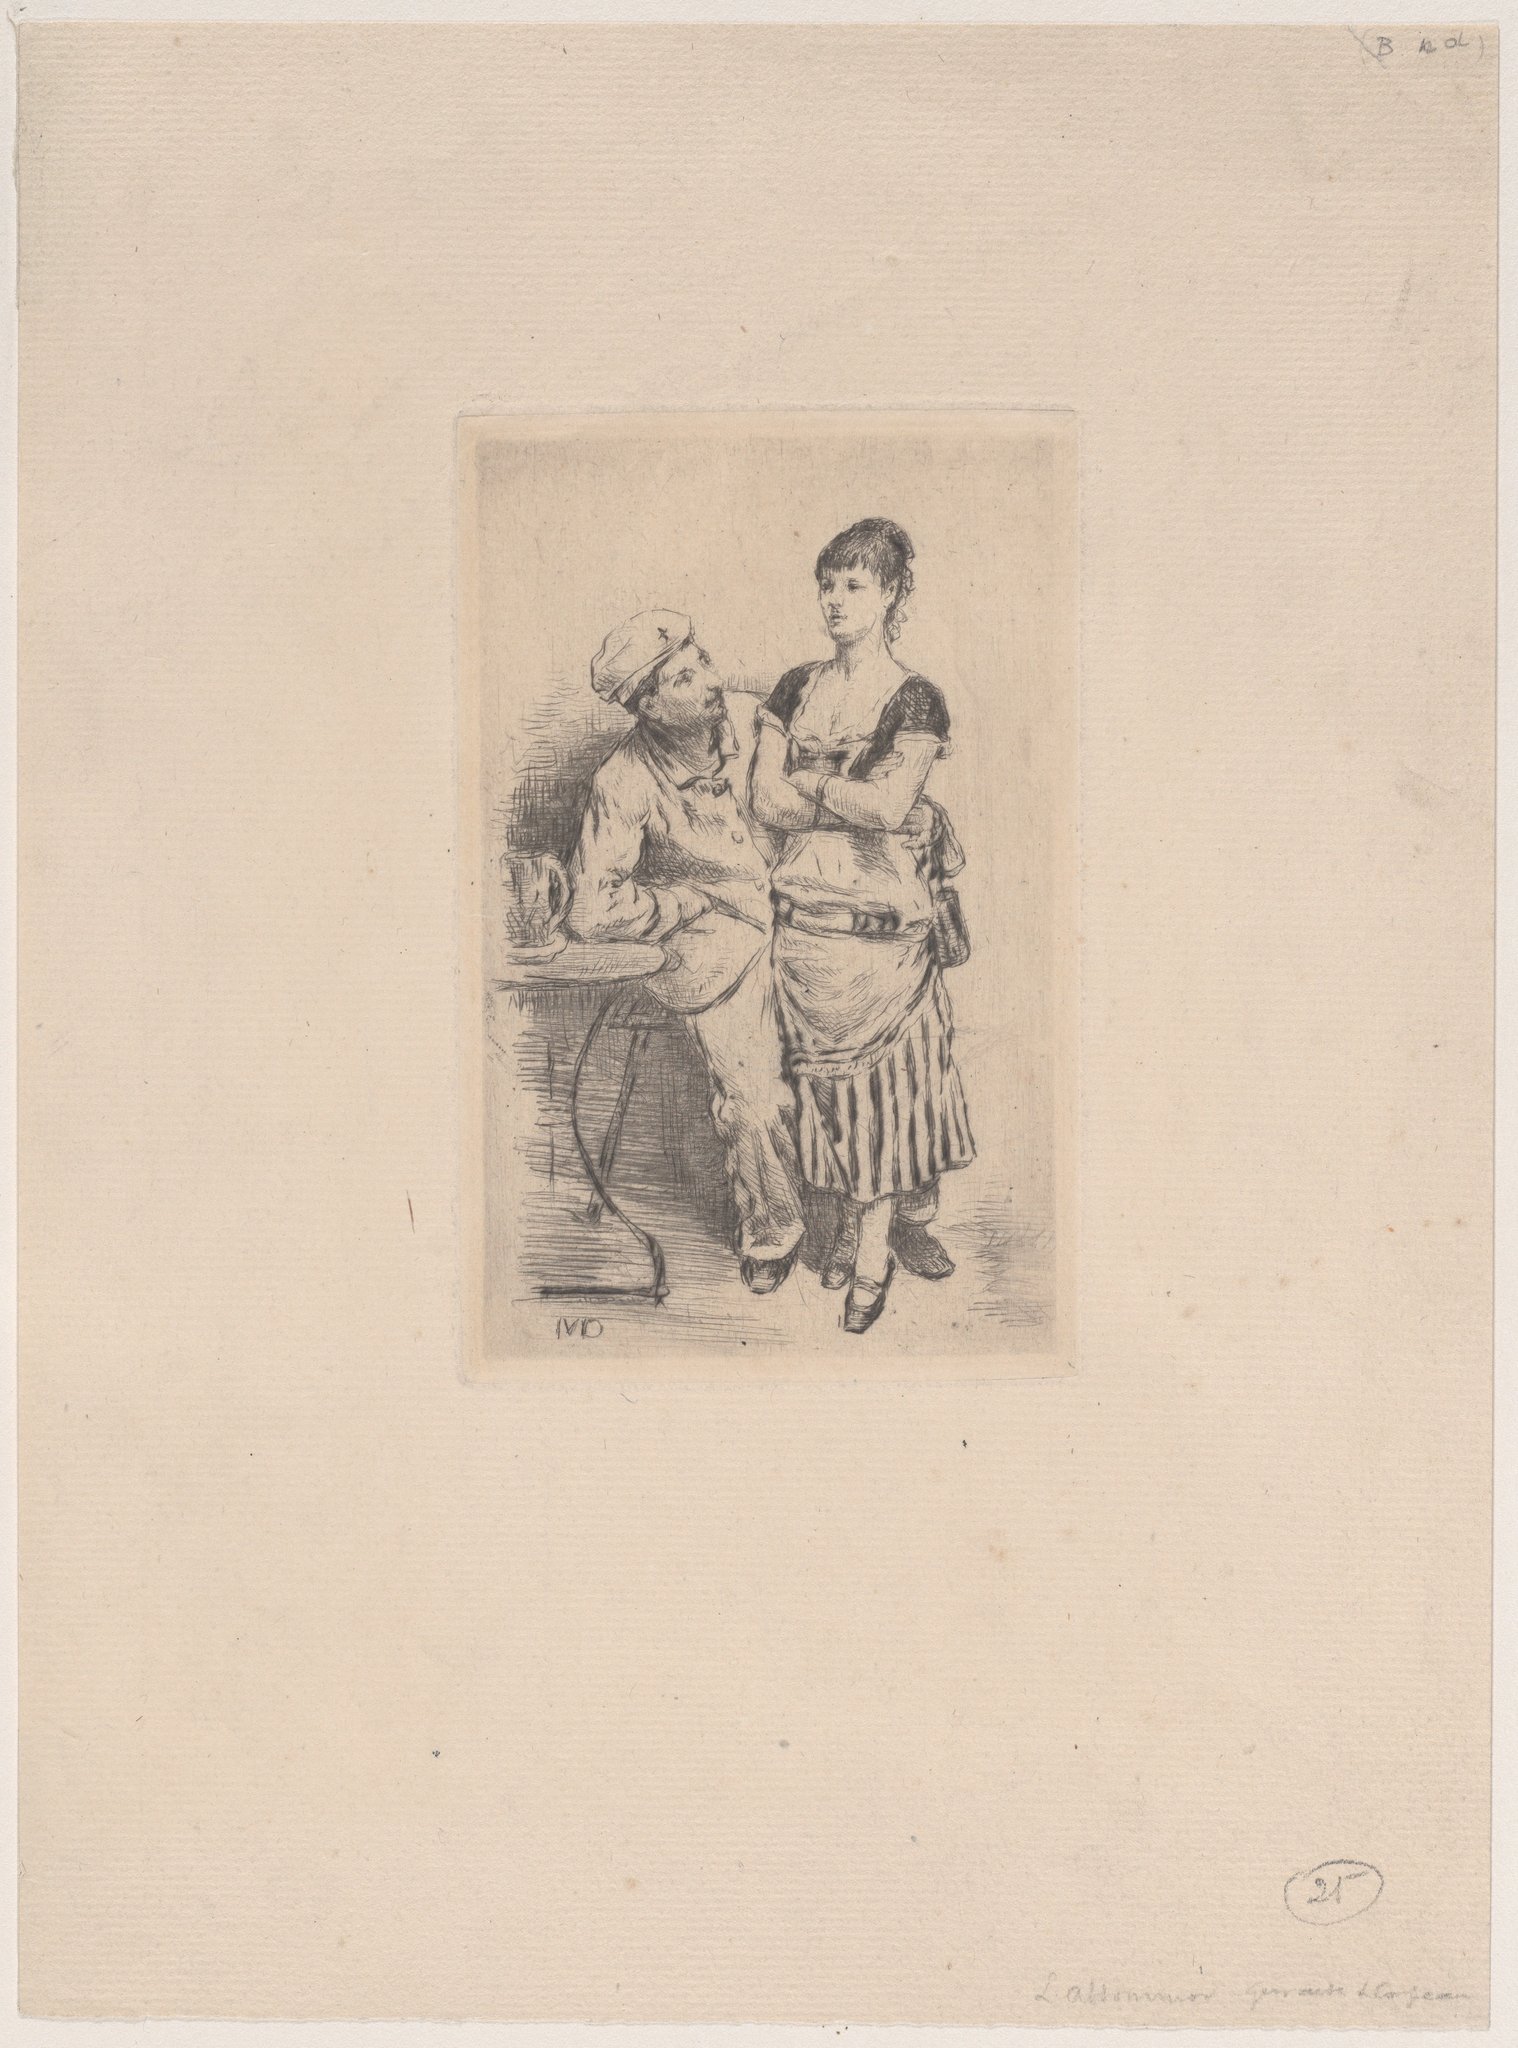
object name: print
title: L'Assommoir, ou scène de brasserie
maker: marcellin desboutin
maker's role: artist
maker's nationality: french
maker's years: 1823-1902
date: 1886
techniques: drypoint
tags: men,women